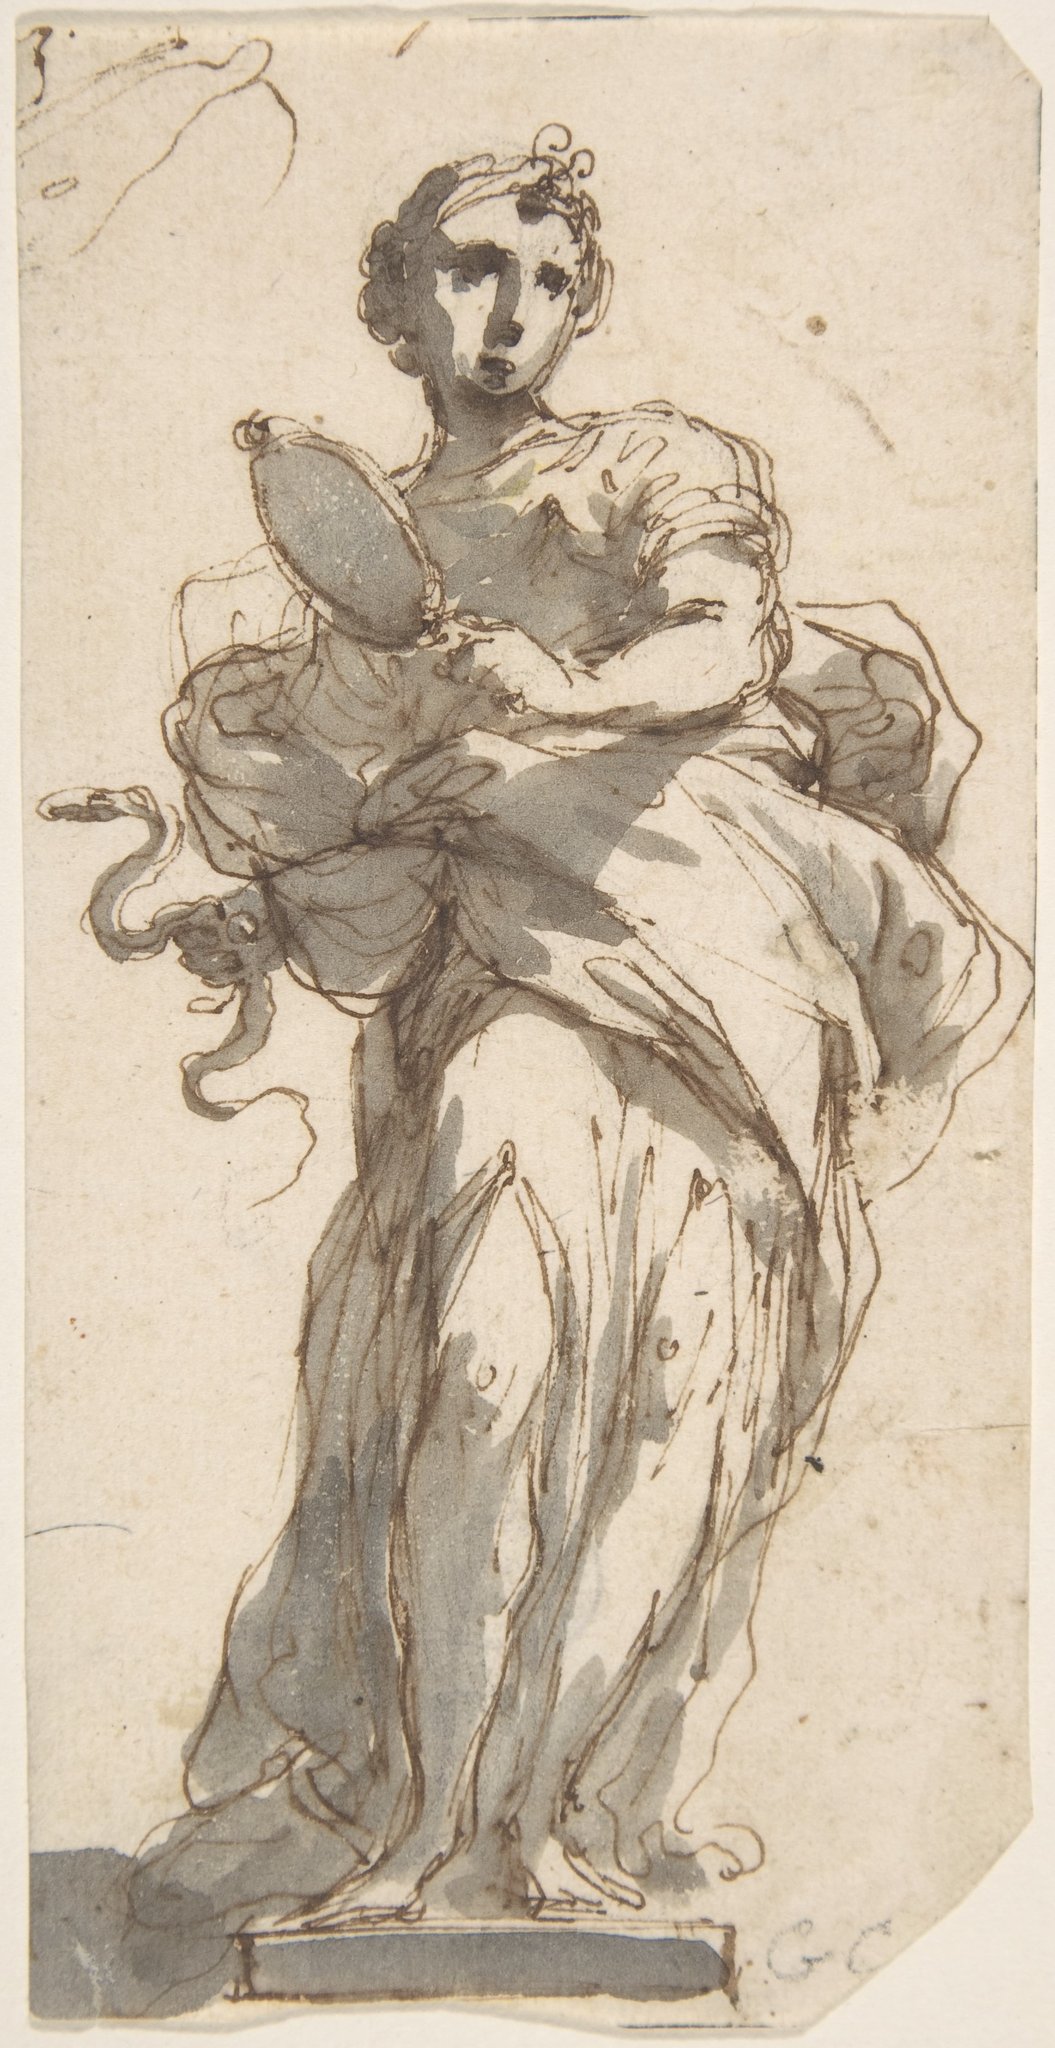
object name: drawing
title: Design for a Statue of Prudence with Sketches at Upper Left Corner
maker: giuseppe bernardino bison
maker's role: artist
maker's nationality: italian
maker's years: 1762-1844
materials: chalk, ink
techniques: brush, pen, wash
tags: women,mirrors